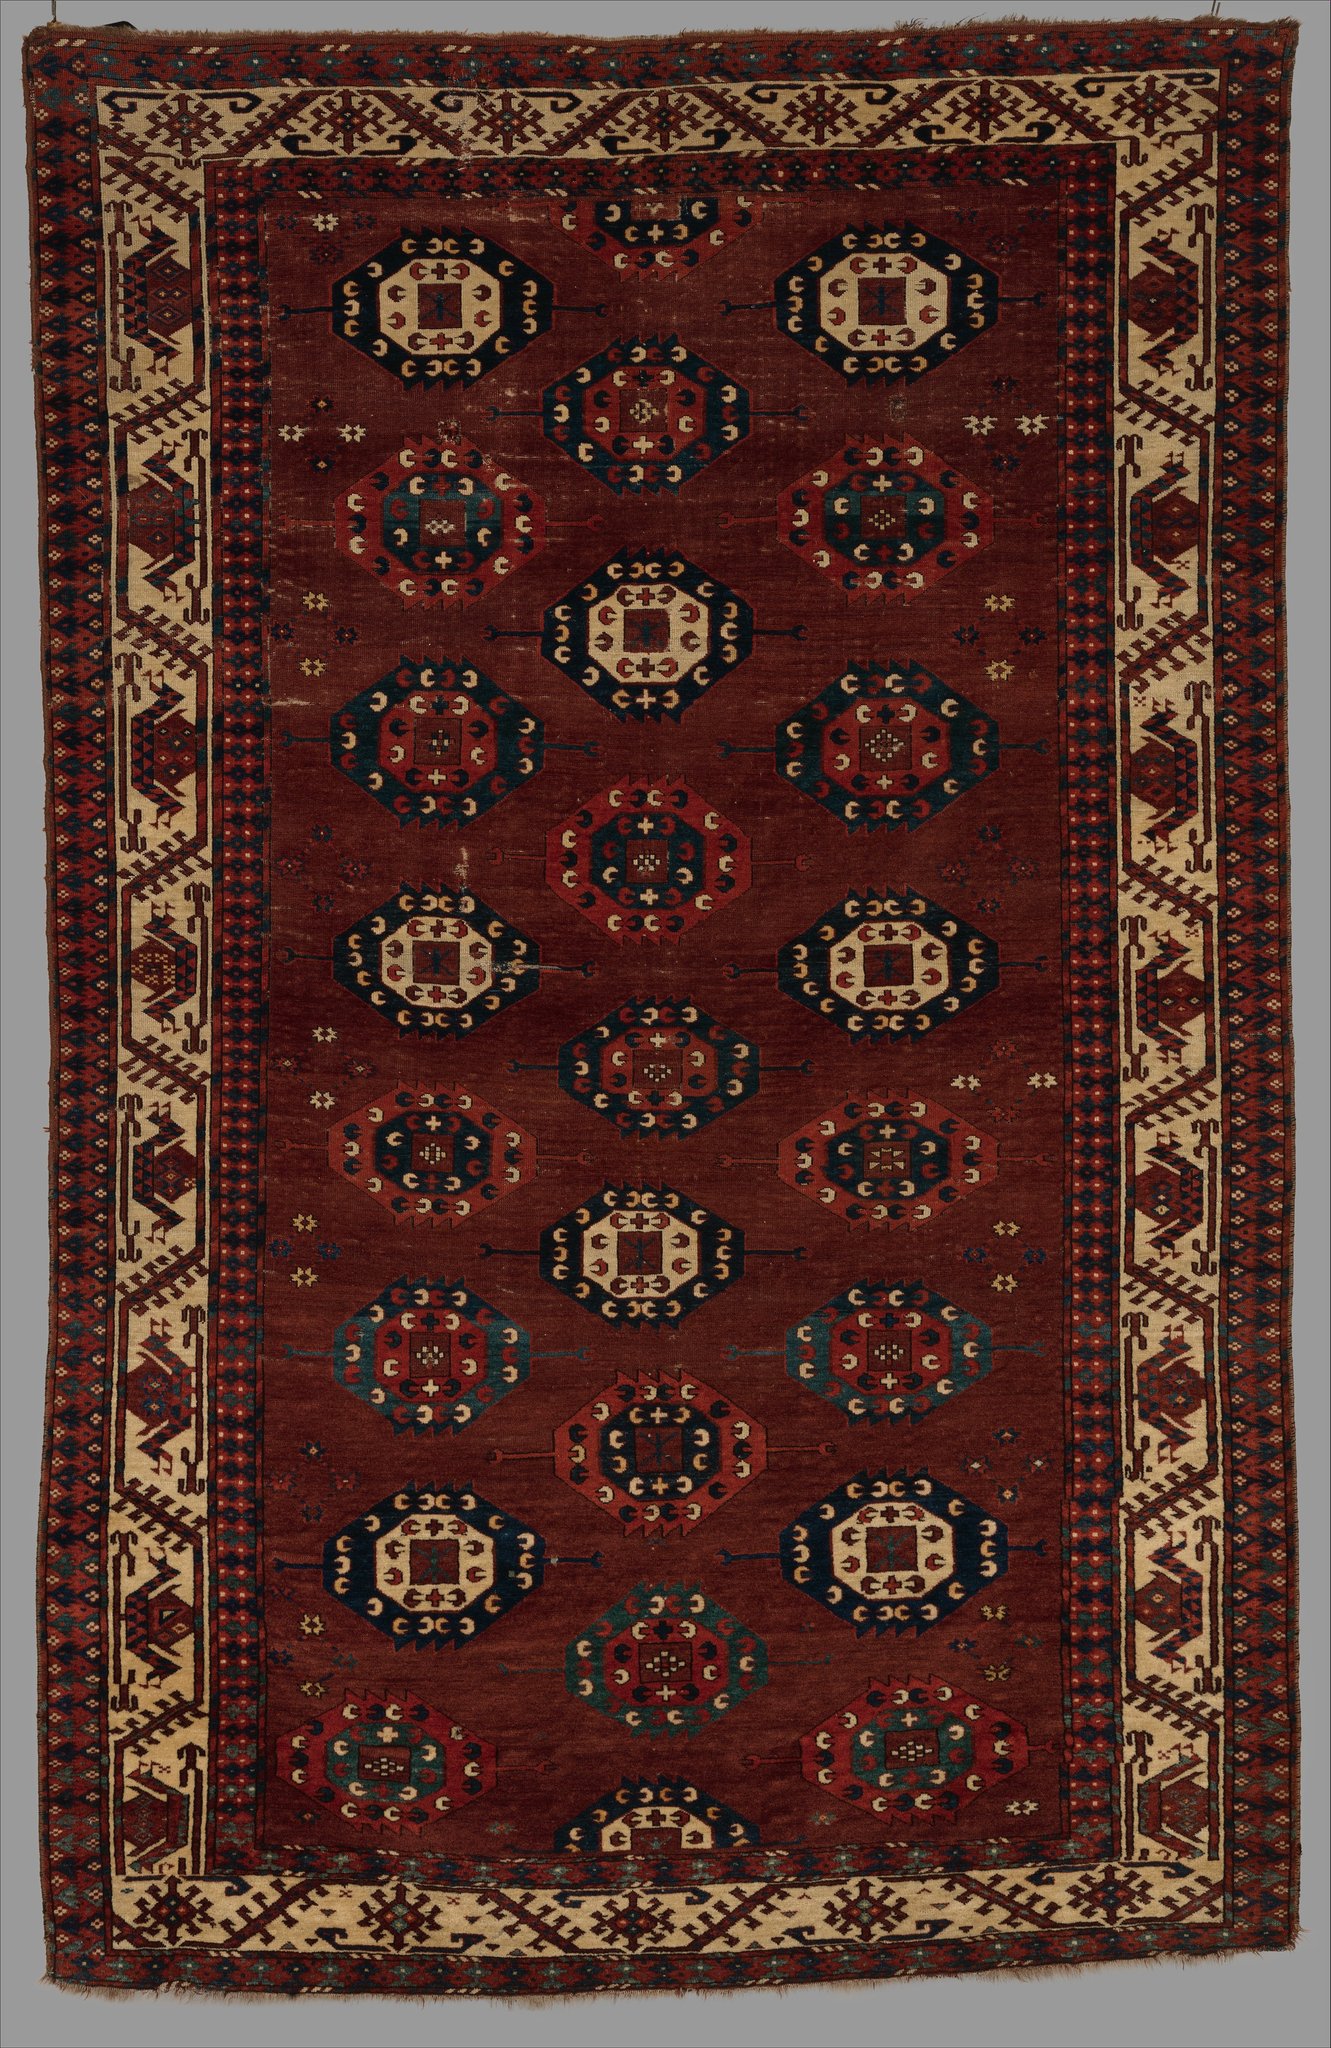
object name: carpet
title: Yomut Main Carpet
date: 1767-1800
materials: cotton, wool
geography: western turkmenistan